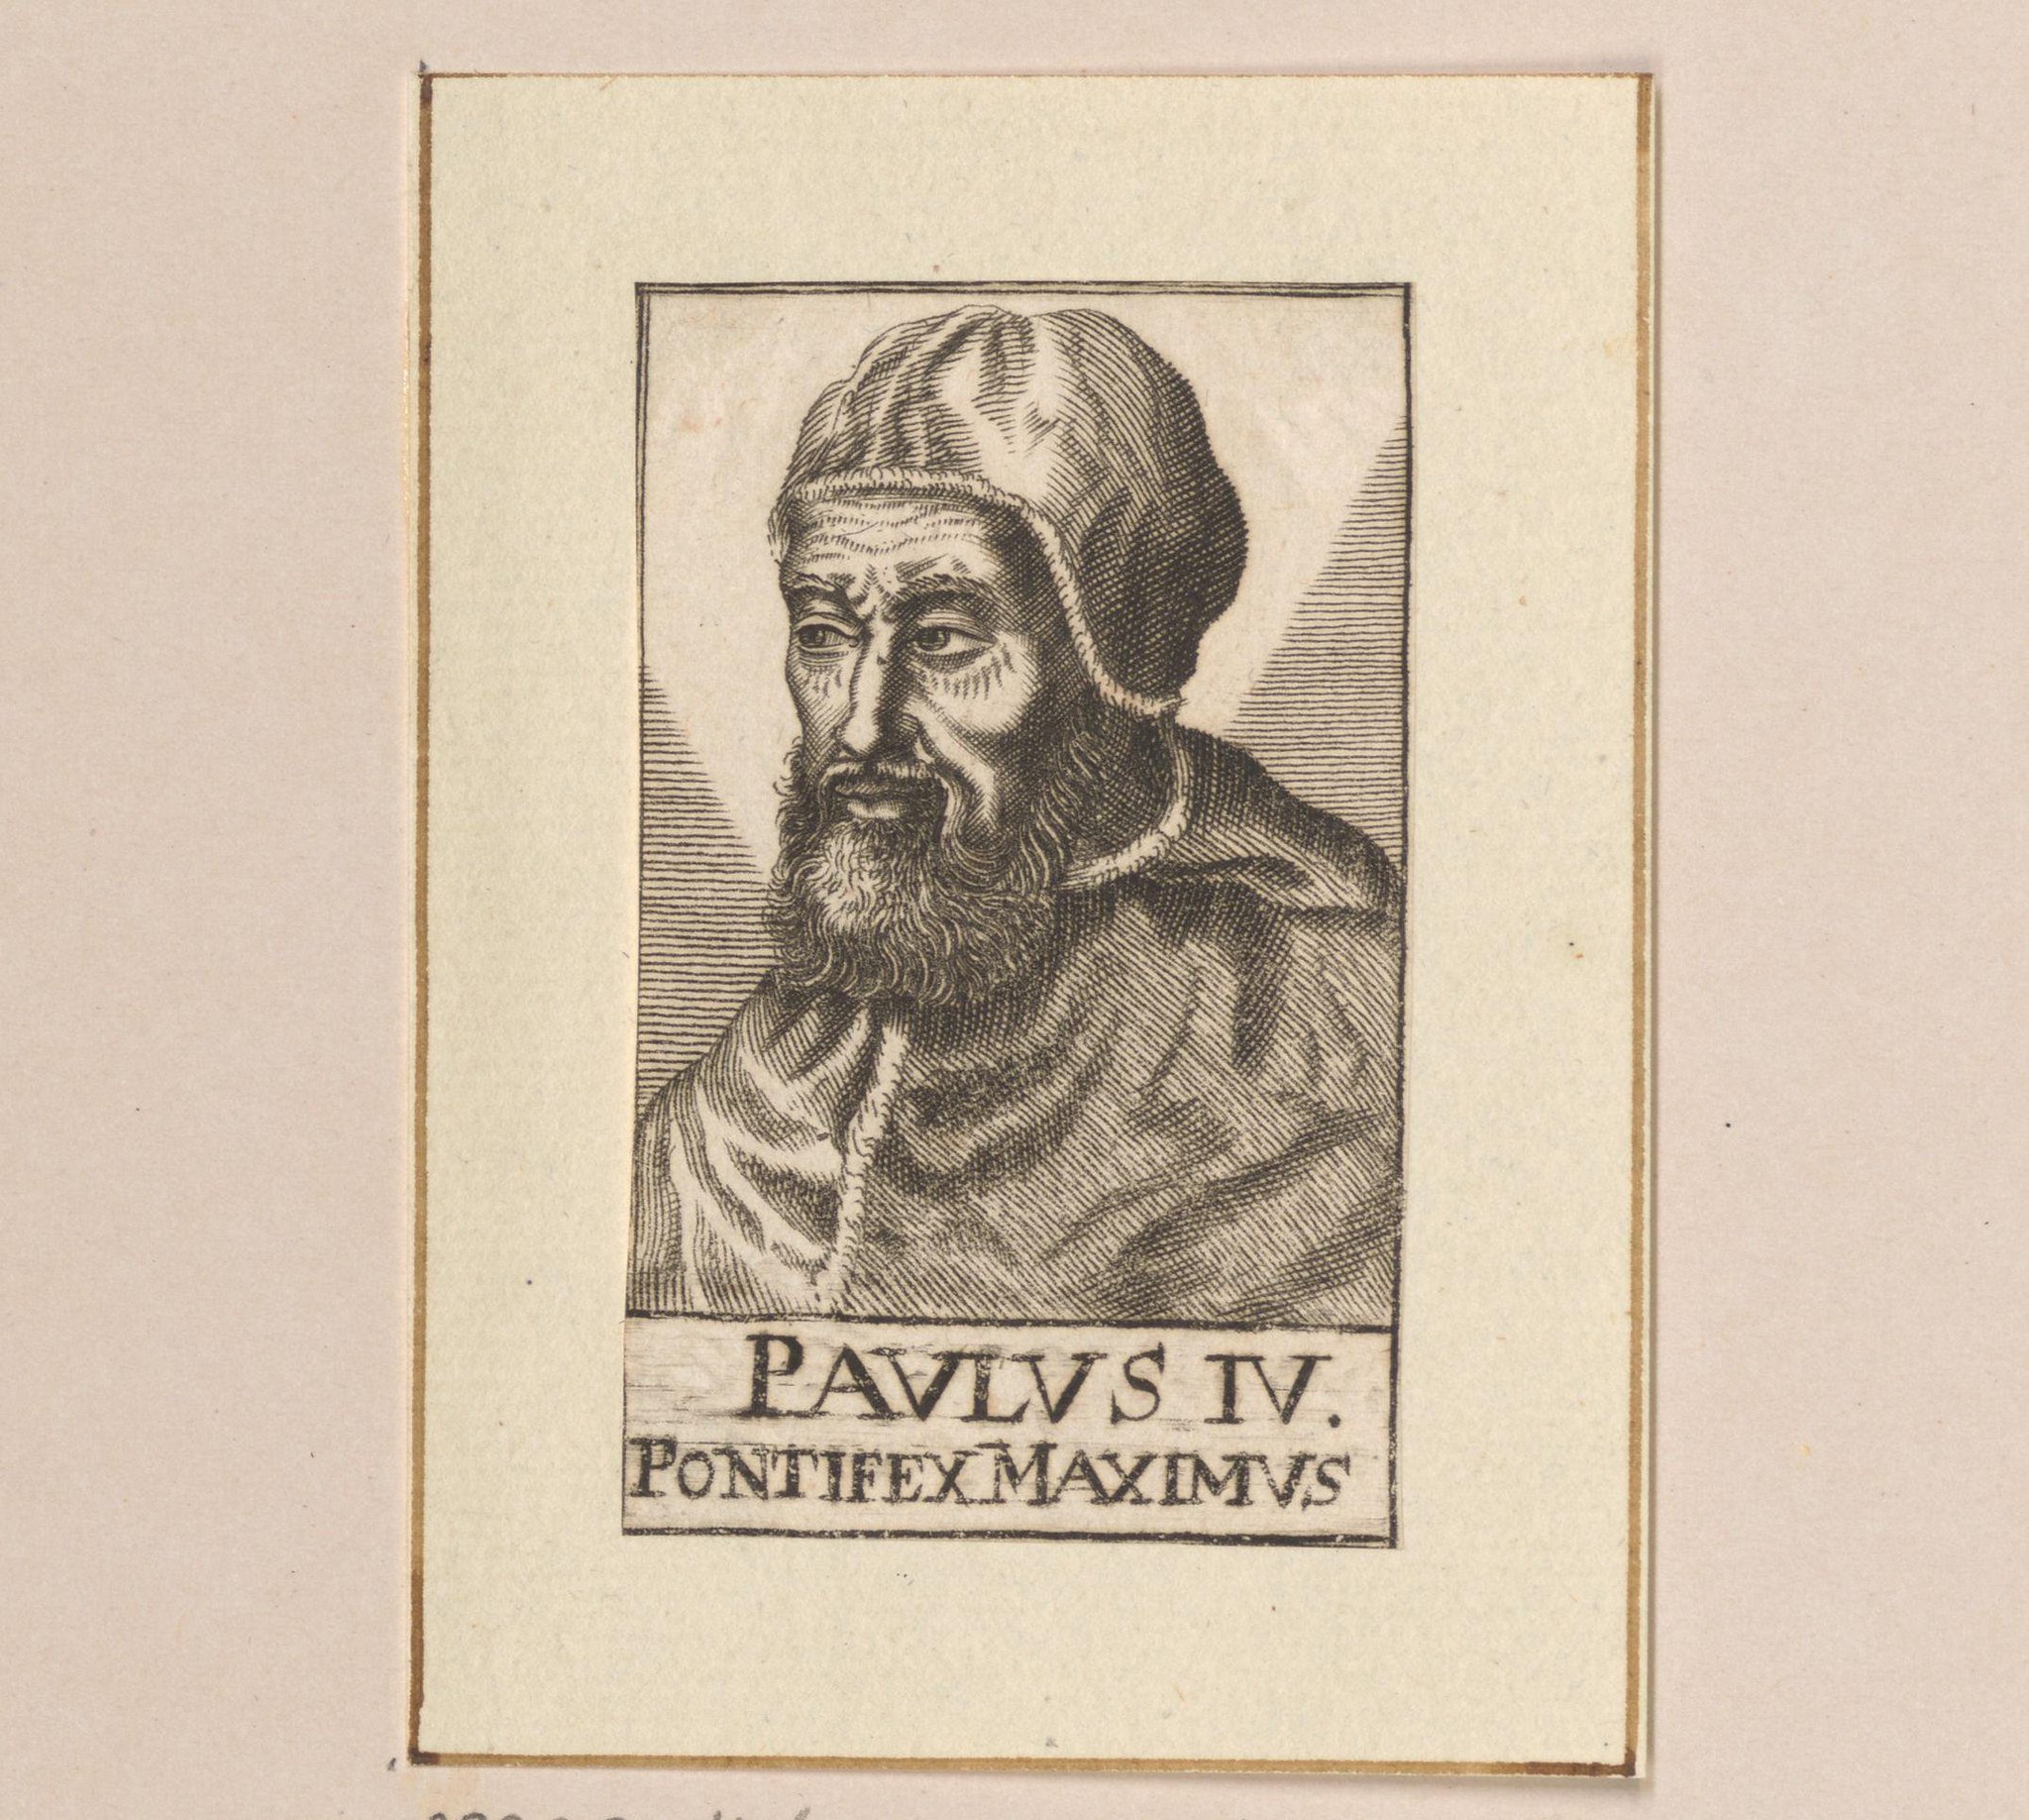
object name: book illustration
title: Portret van paus Paulus IV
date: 1688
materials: paper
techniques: engraving, etching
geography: nuremberg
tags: adult man, historical persons, pope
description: Prent maakt deel uit van een grotere prent die later is verknipt. Prent uit: Freher, Paul. Theatrum virorum eruditione clarorum. Neurenberg: Johann Hoffmann, 1688.